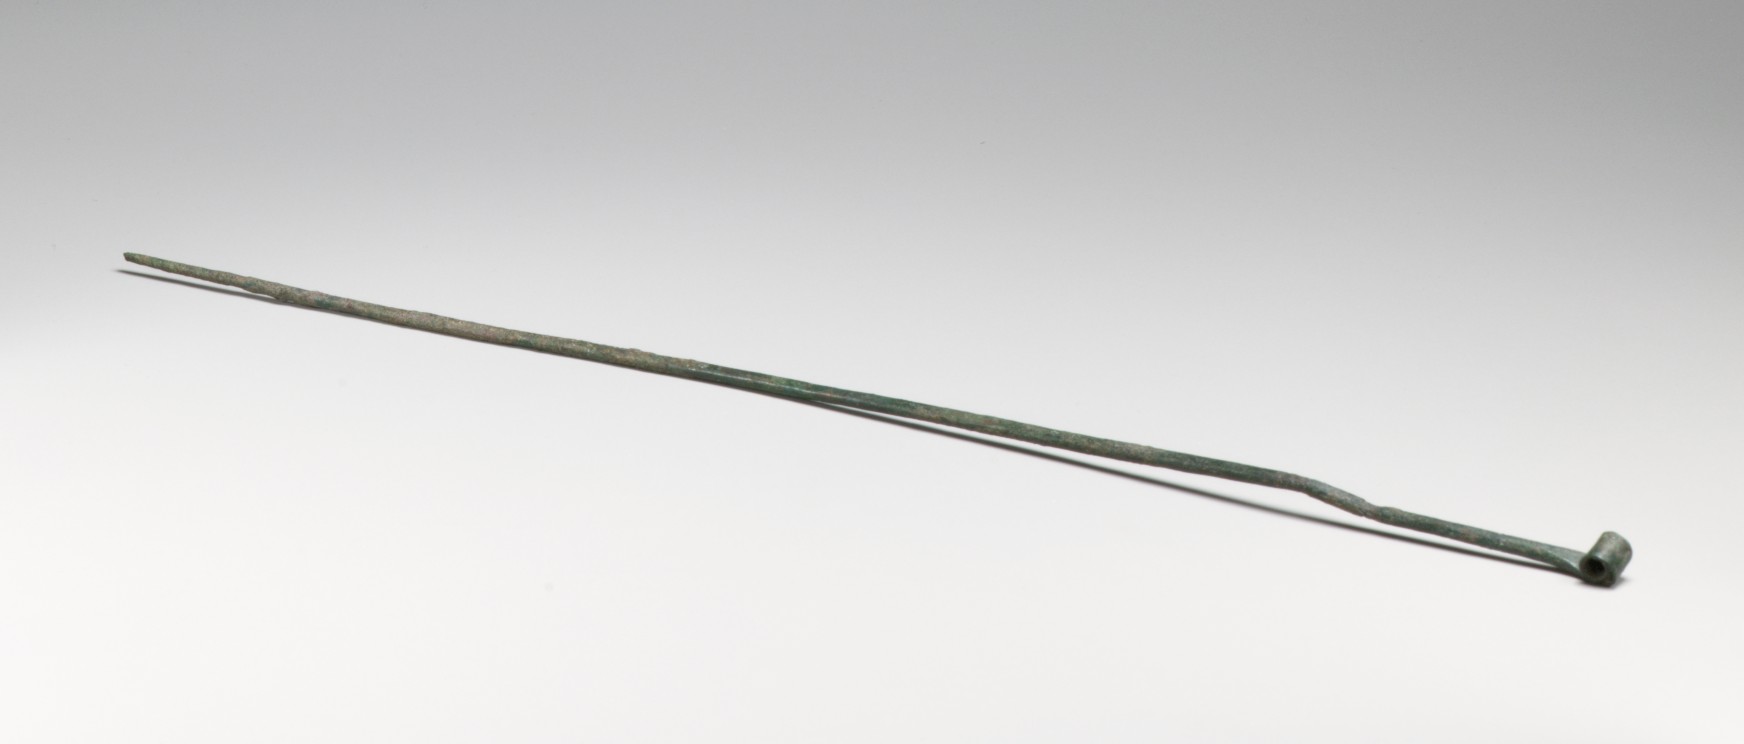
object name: pin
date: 7000 BCE-330 CE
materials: bronze